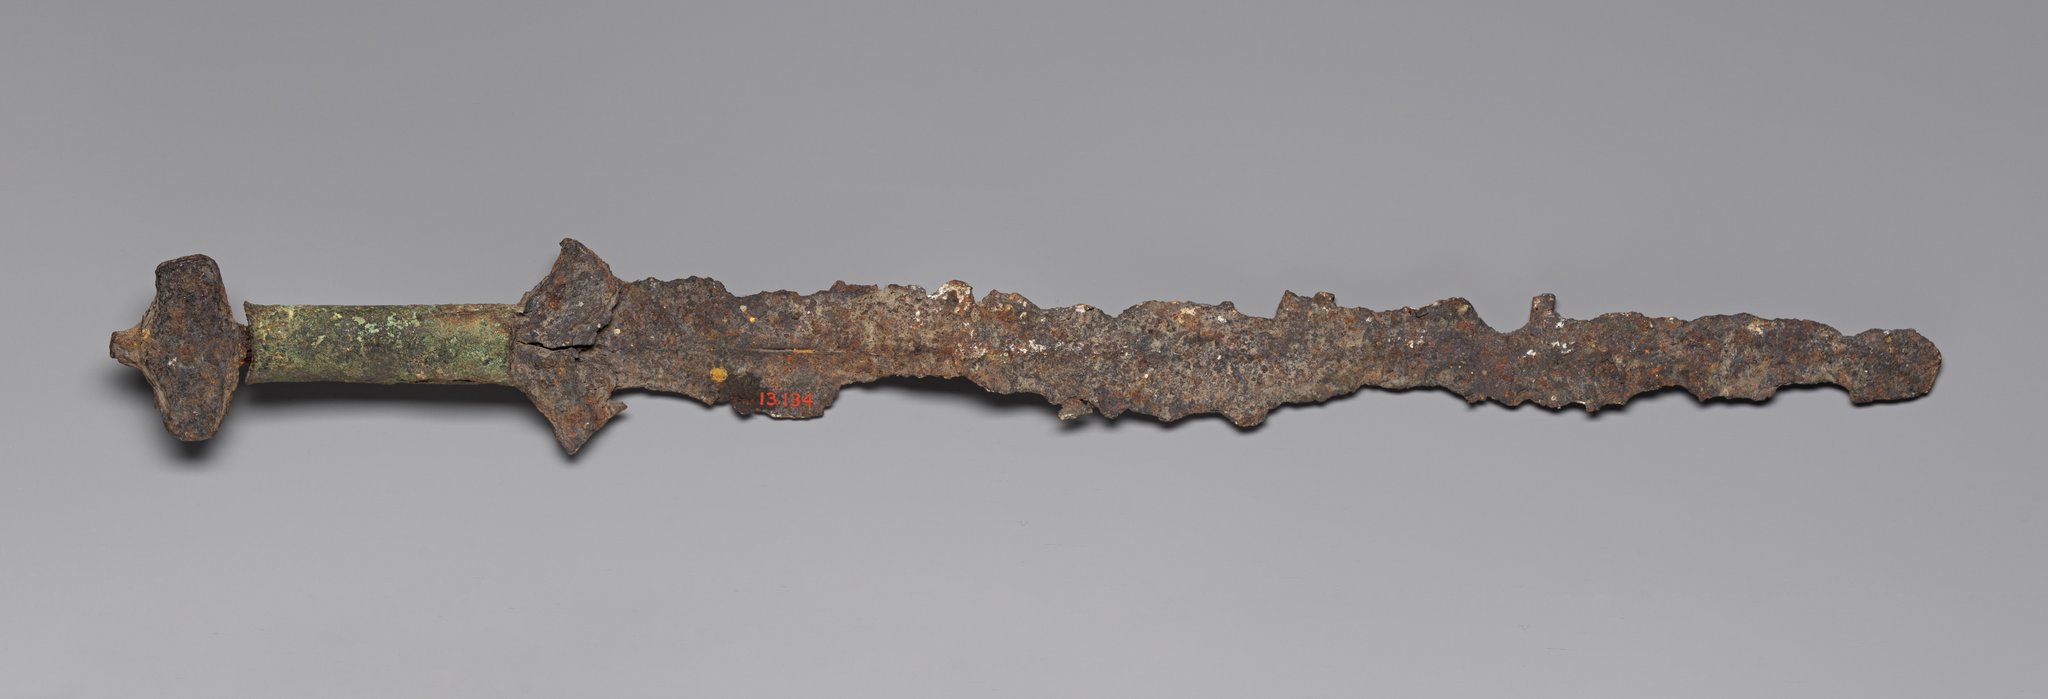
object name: sword with bronze handle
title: Iron sword with bronze hilt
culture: roman, gaul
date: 101-200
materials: bronze, iron